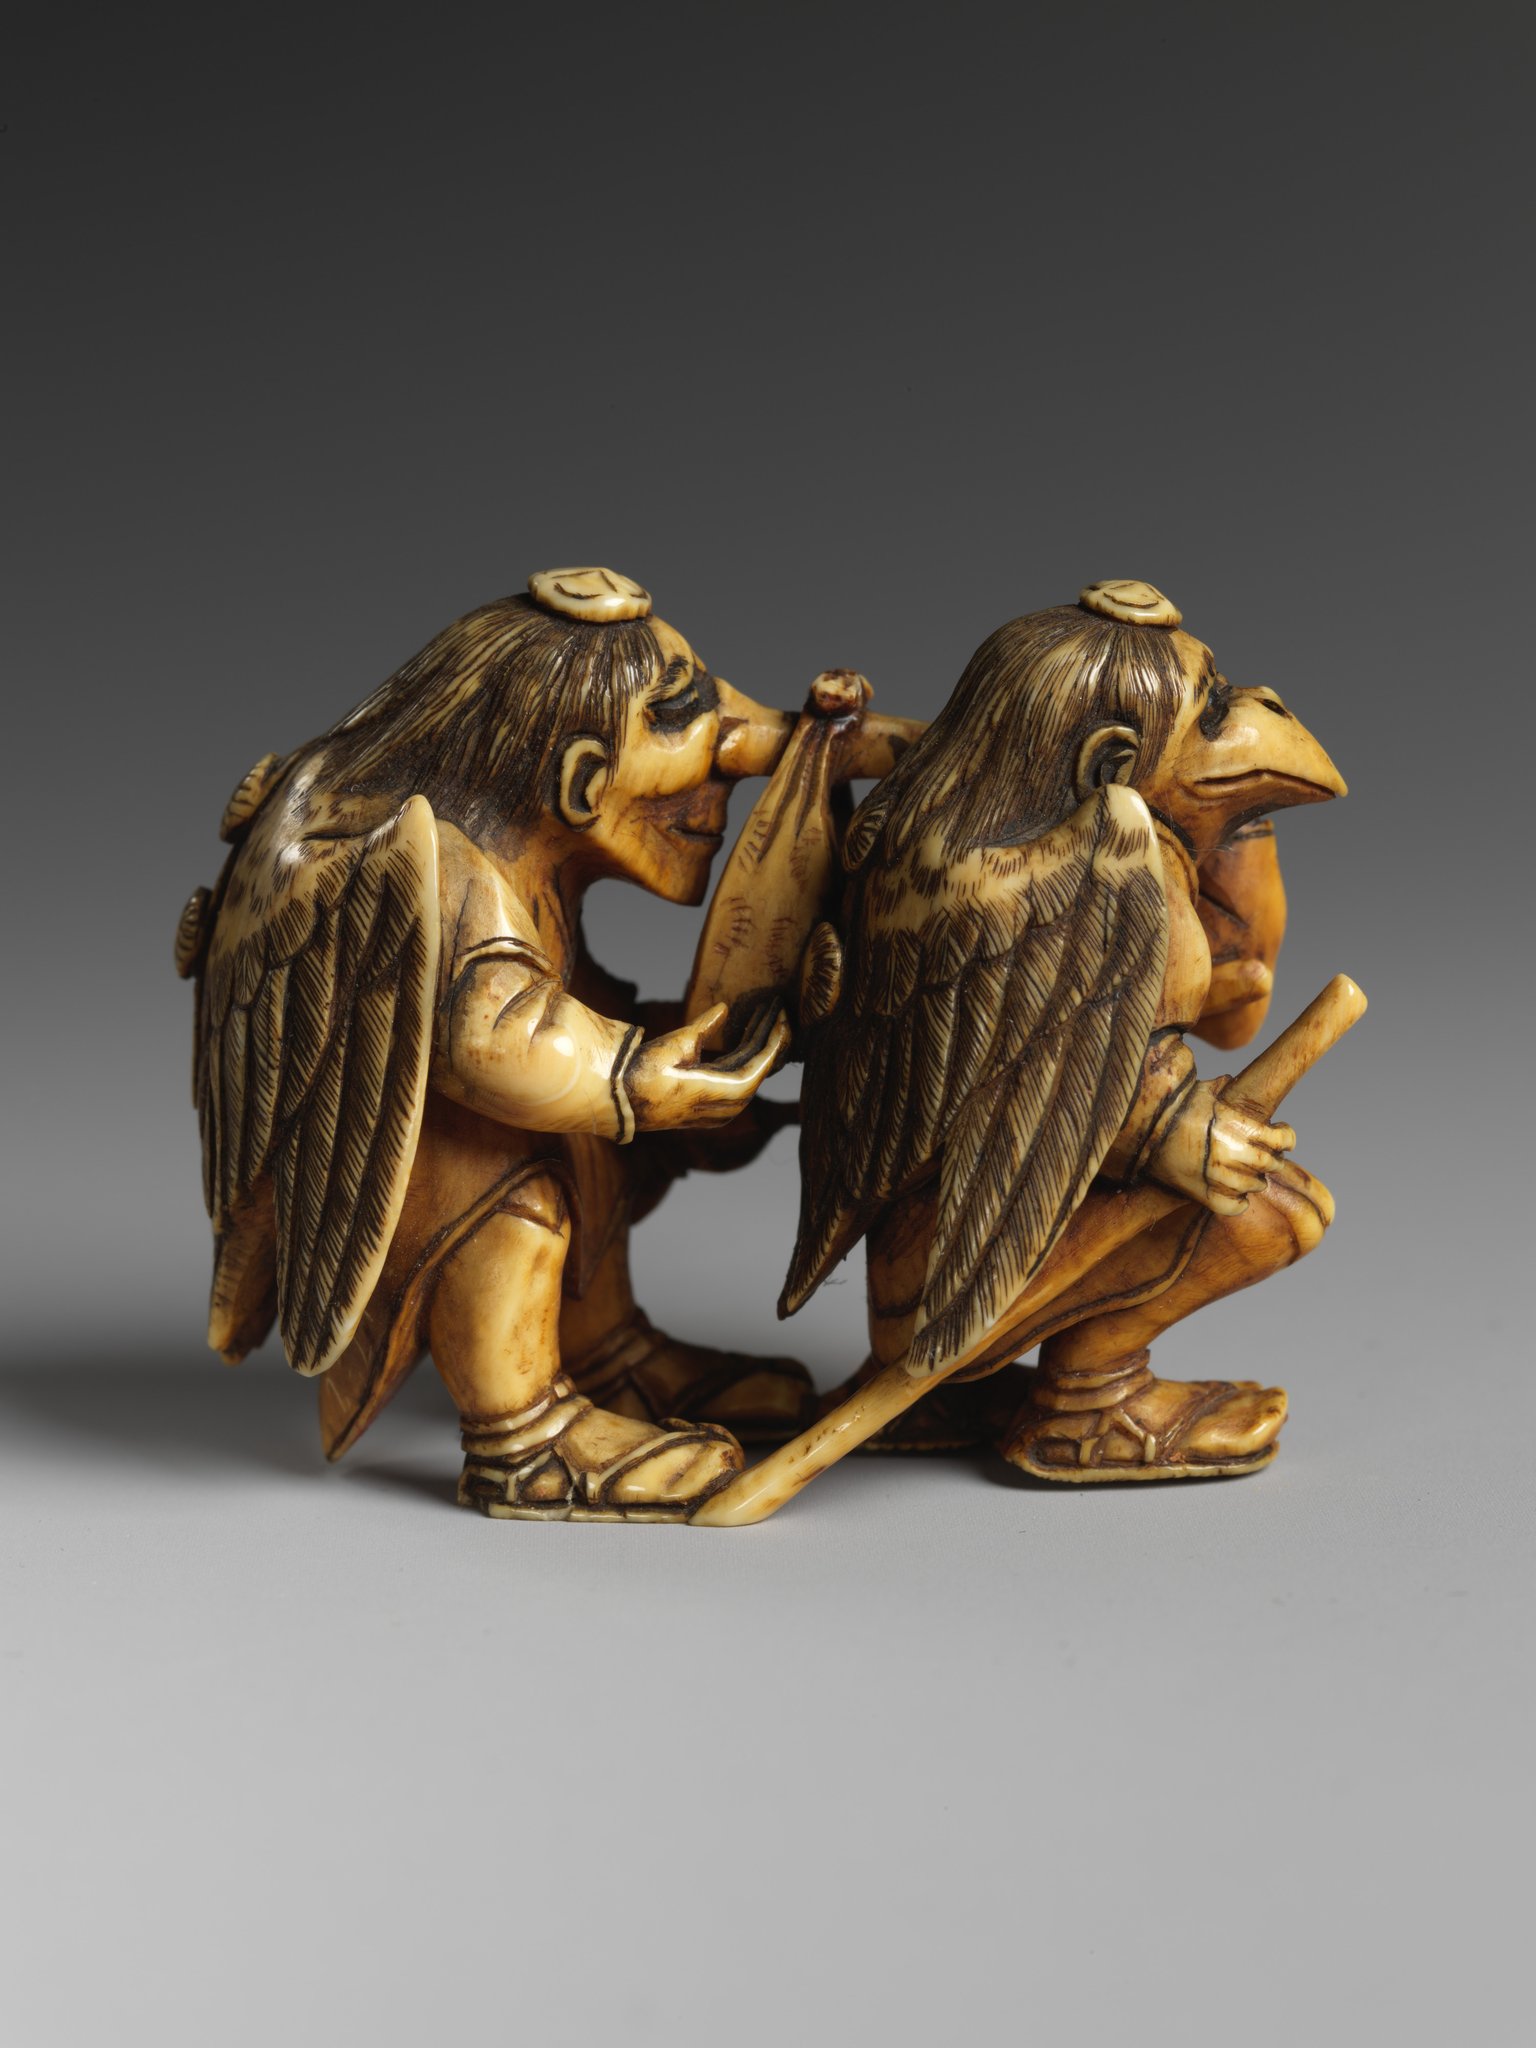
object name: netsuke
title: Two Mythical Creatures (Tengu) Carrying a Parcel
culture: japanese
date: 1851-1900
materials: ivory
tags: mythical creatures